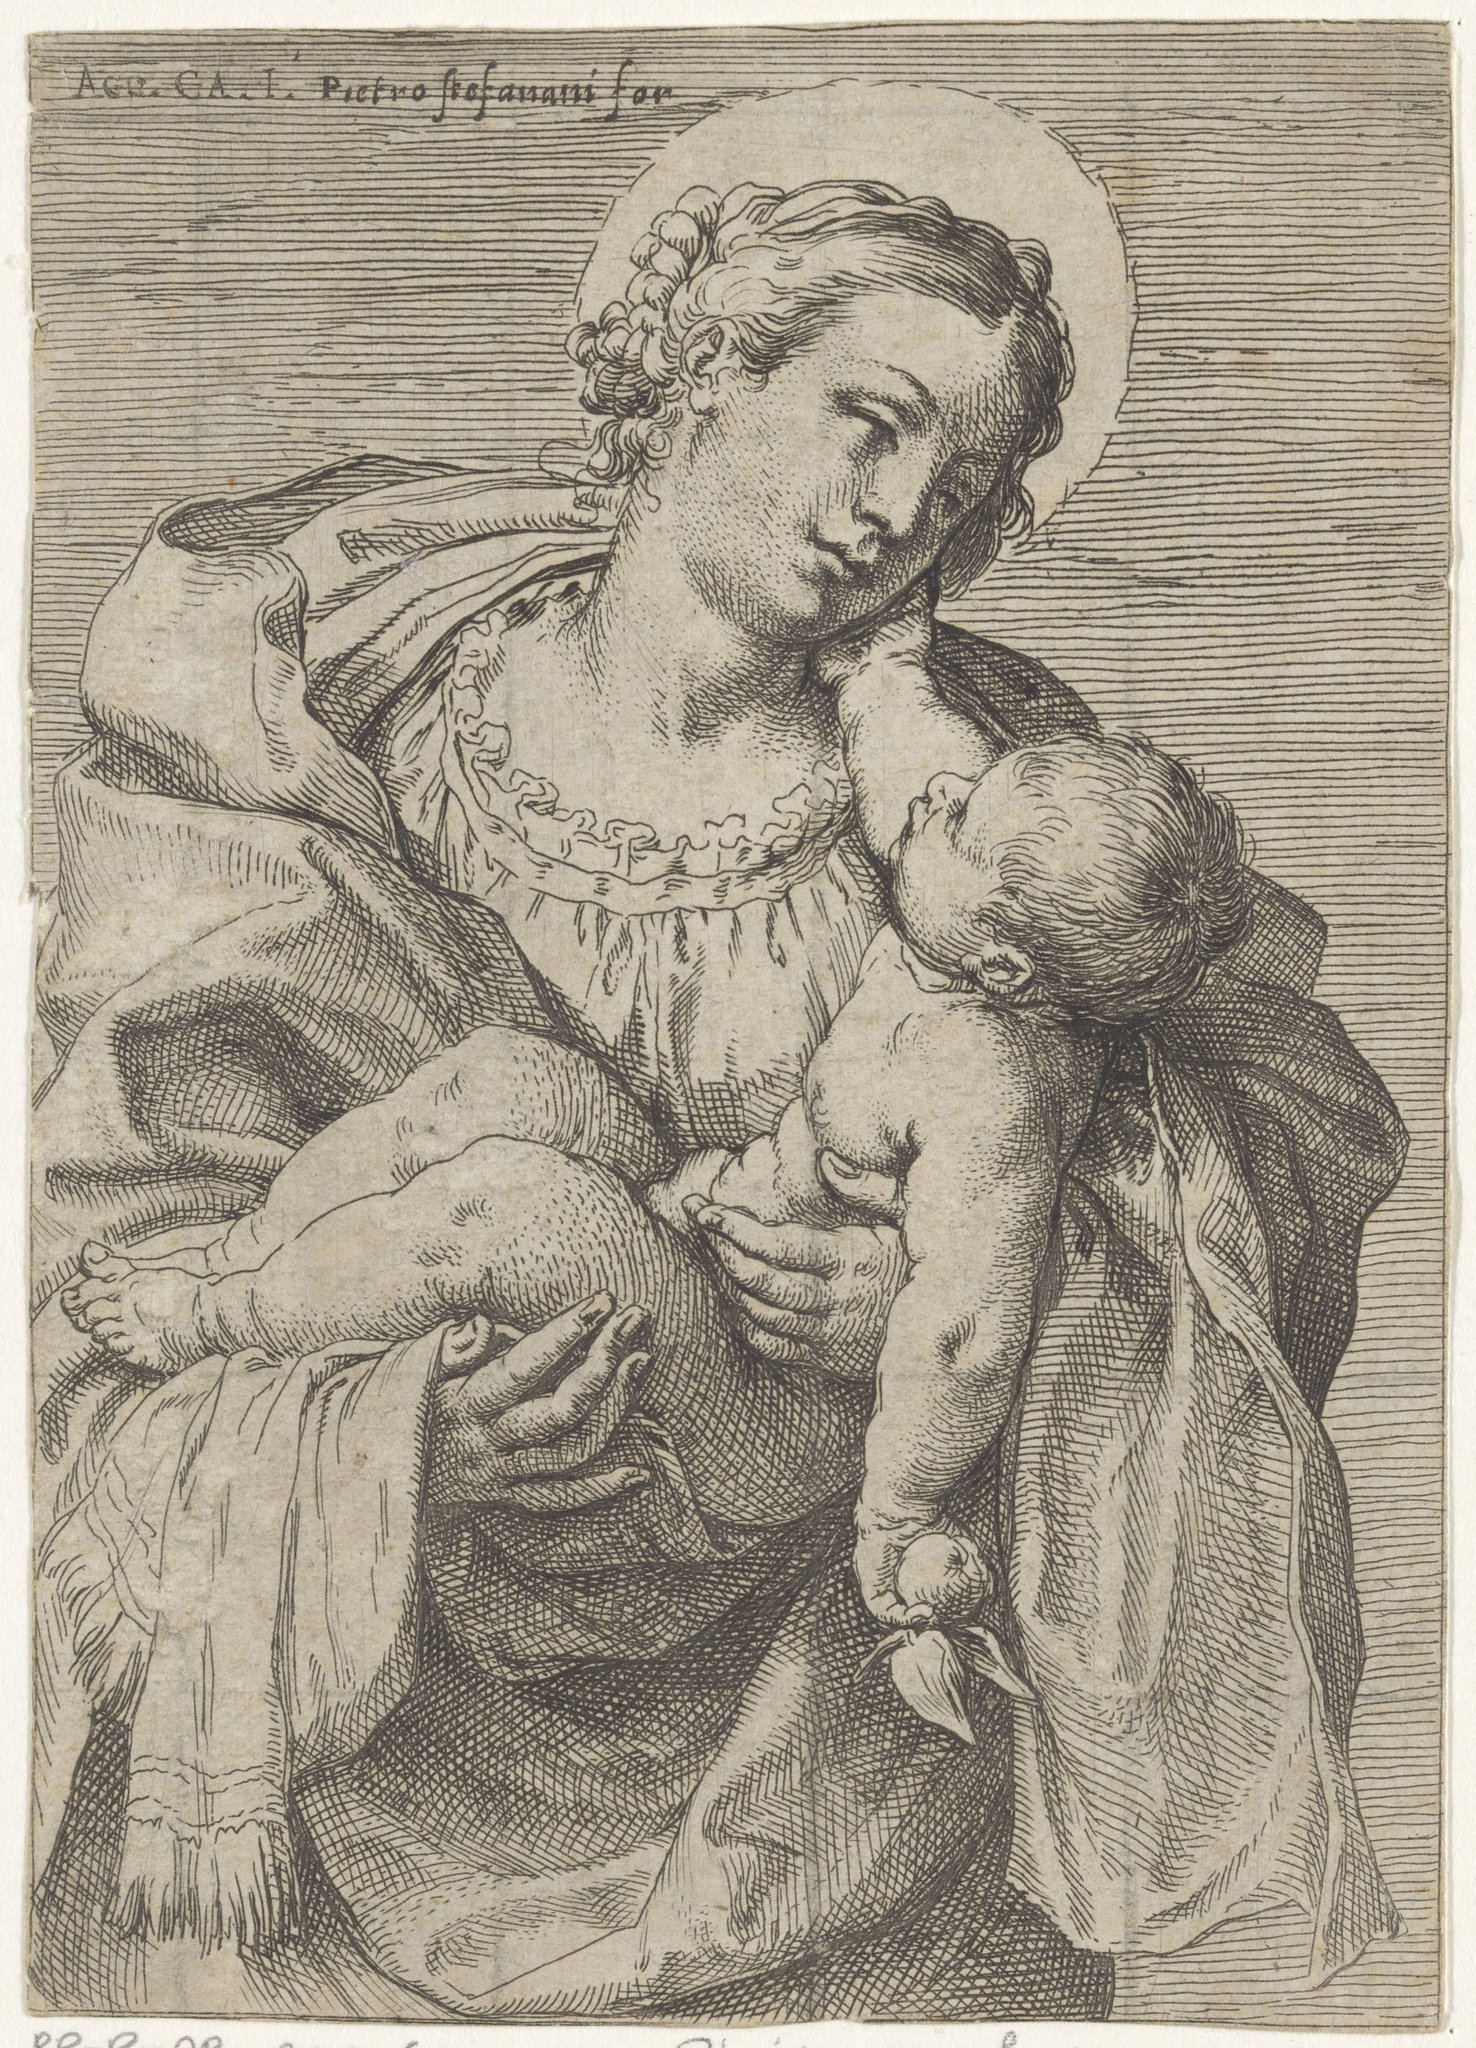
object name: print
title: Maria met Kind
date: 1570-1609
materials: paper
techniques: etching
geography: italy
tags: madonna: i.e. mary with the christ-child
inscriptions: inscription: Lugt 2228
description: In potlood is een raster over de voorstelling aangebracht.